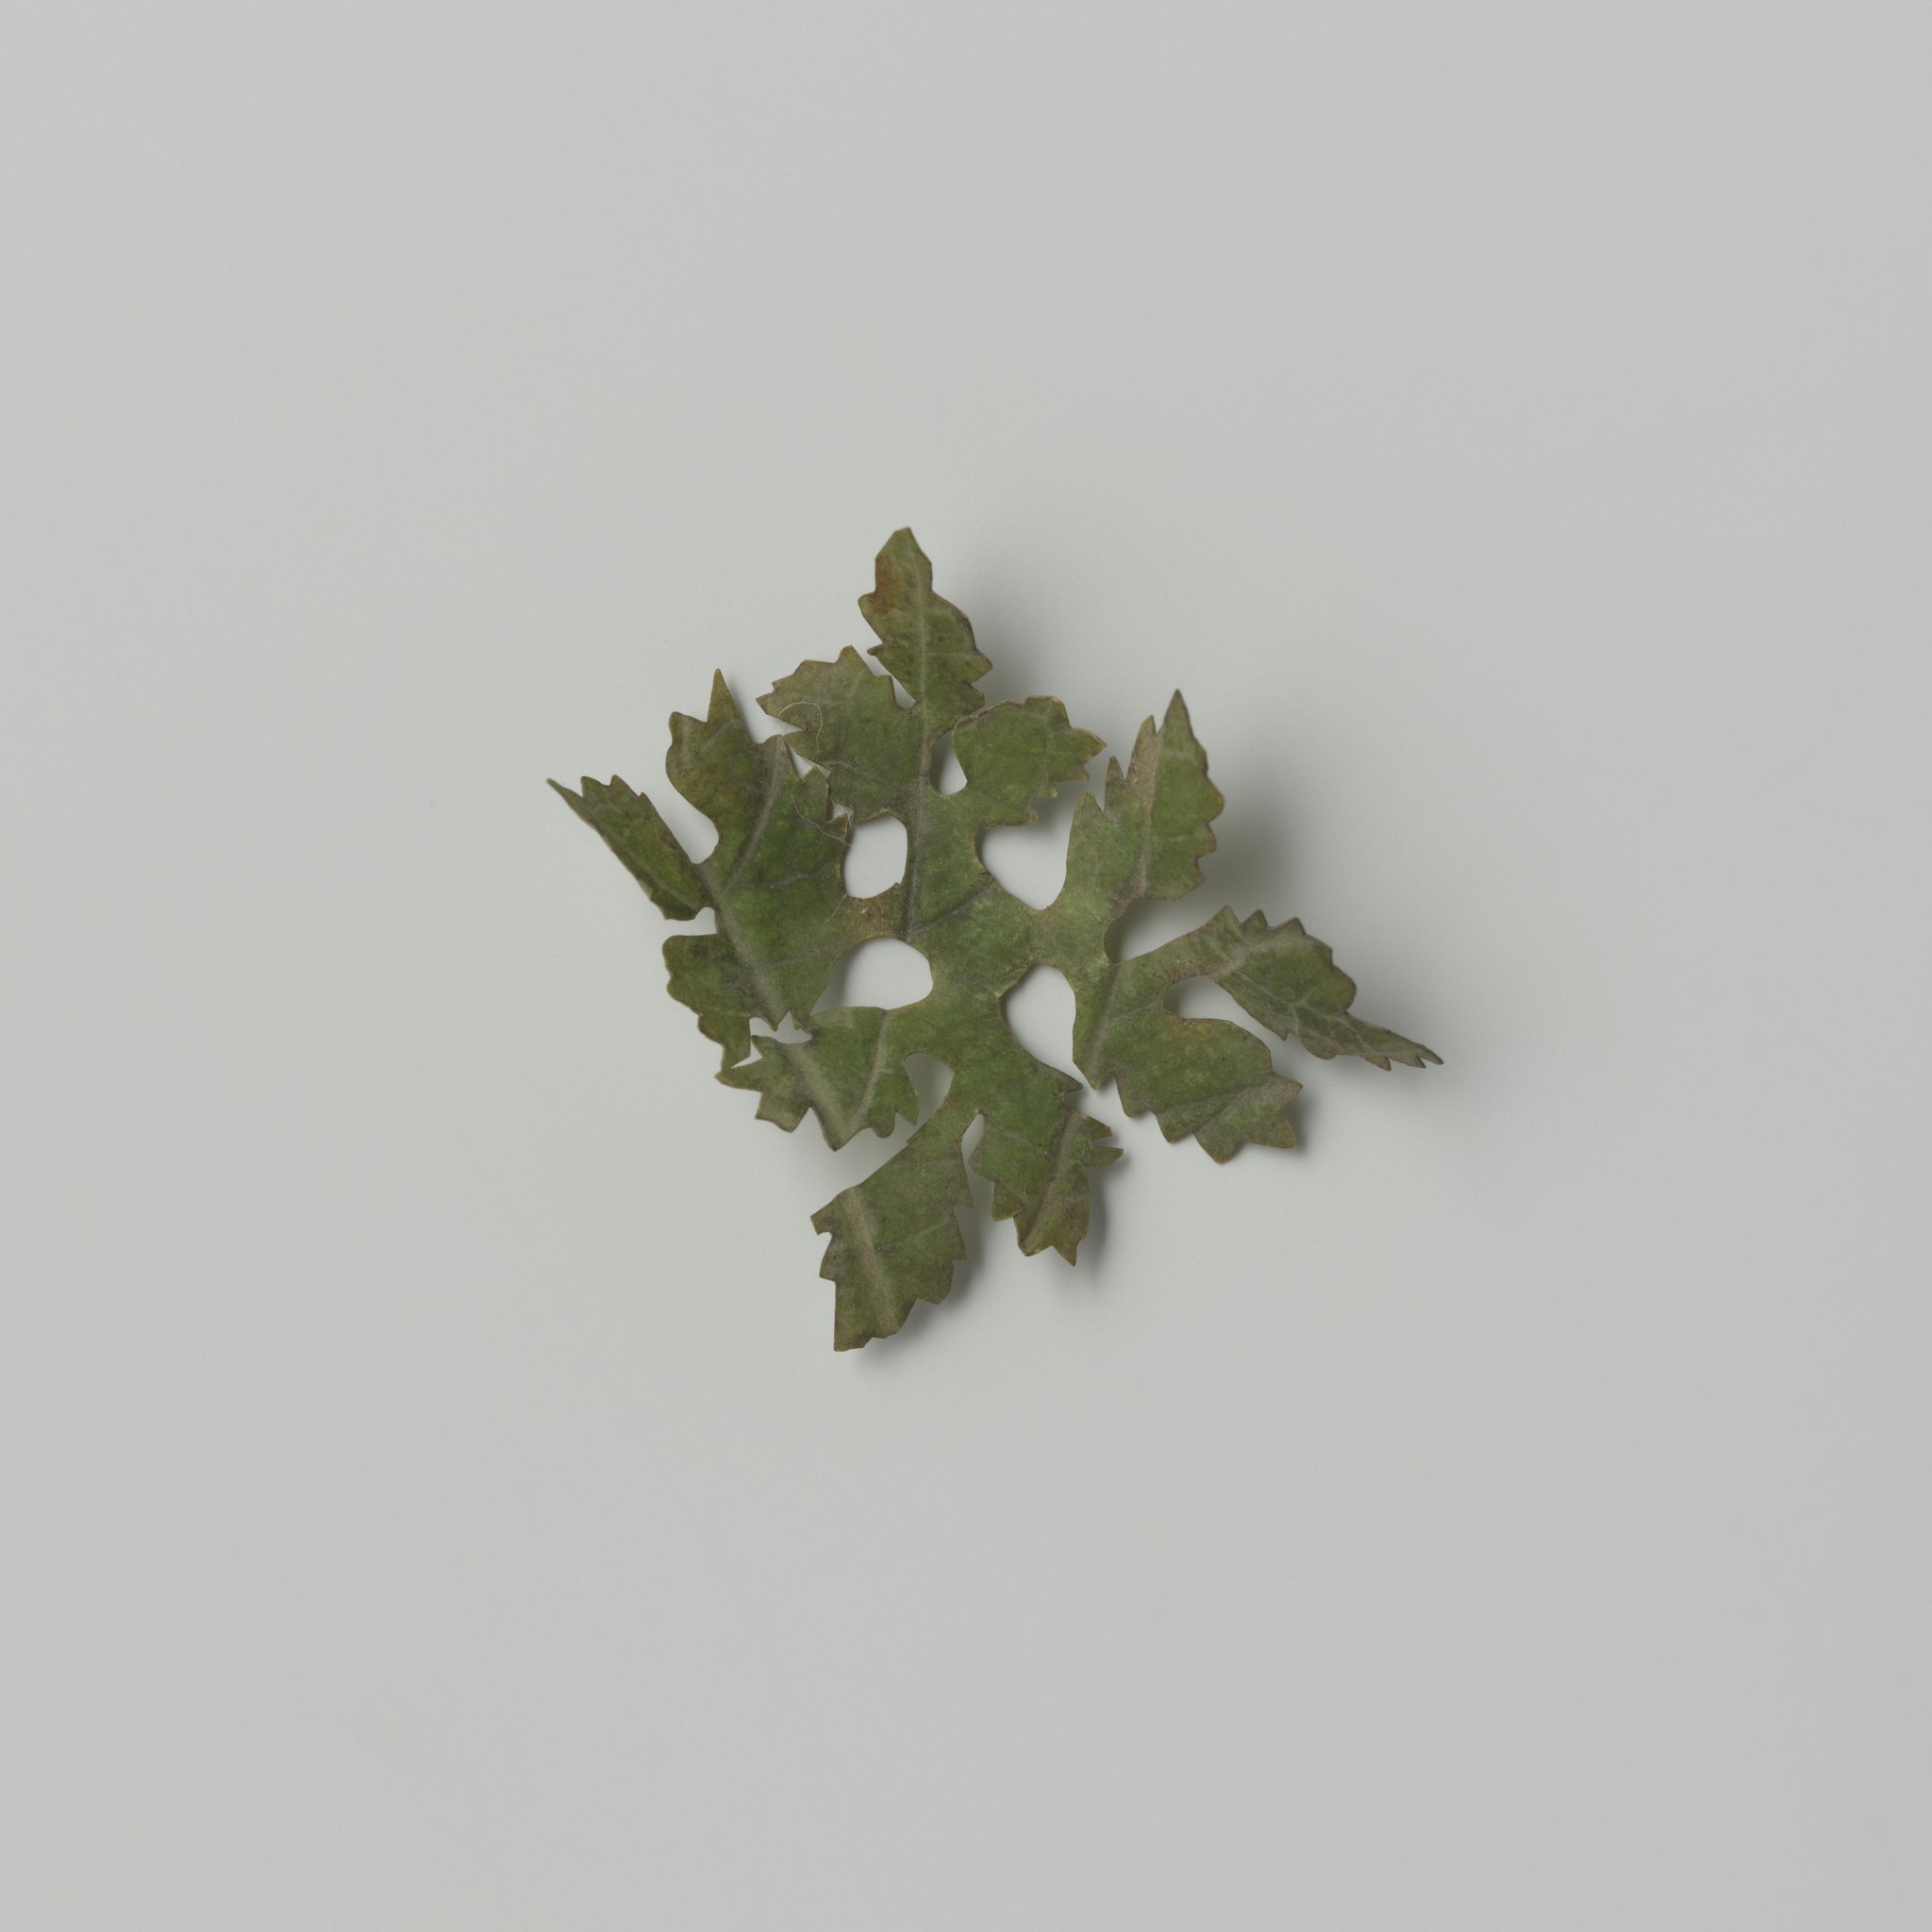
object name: miniature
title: Druiveblad, geknipt uit met nerven geperst en groen / bruin gekleurd perkament (?).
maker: Anonymous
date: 1700-1900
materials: parchment